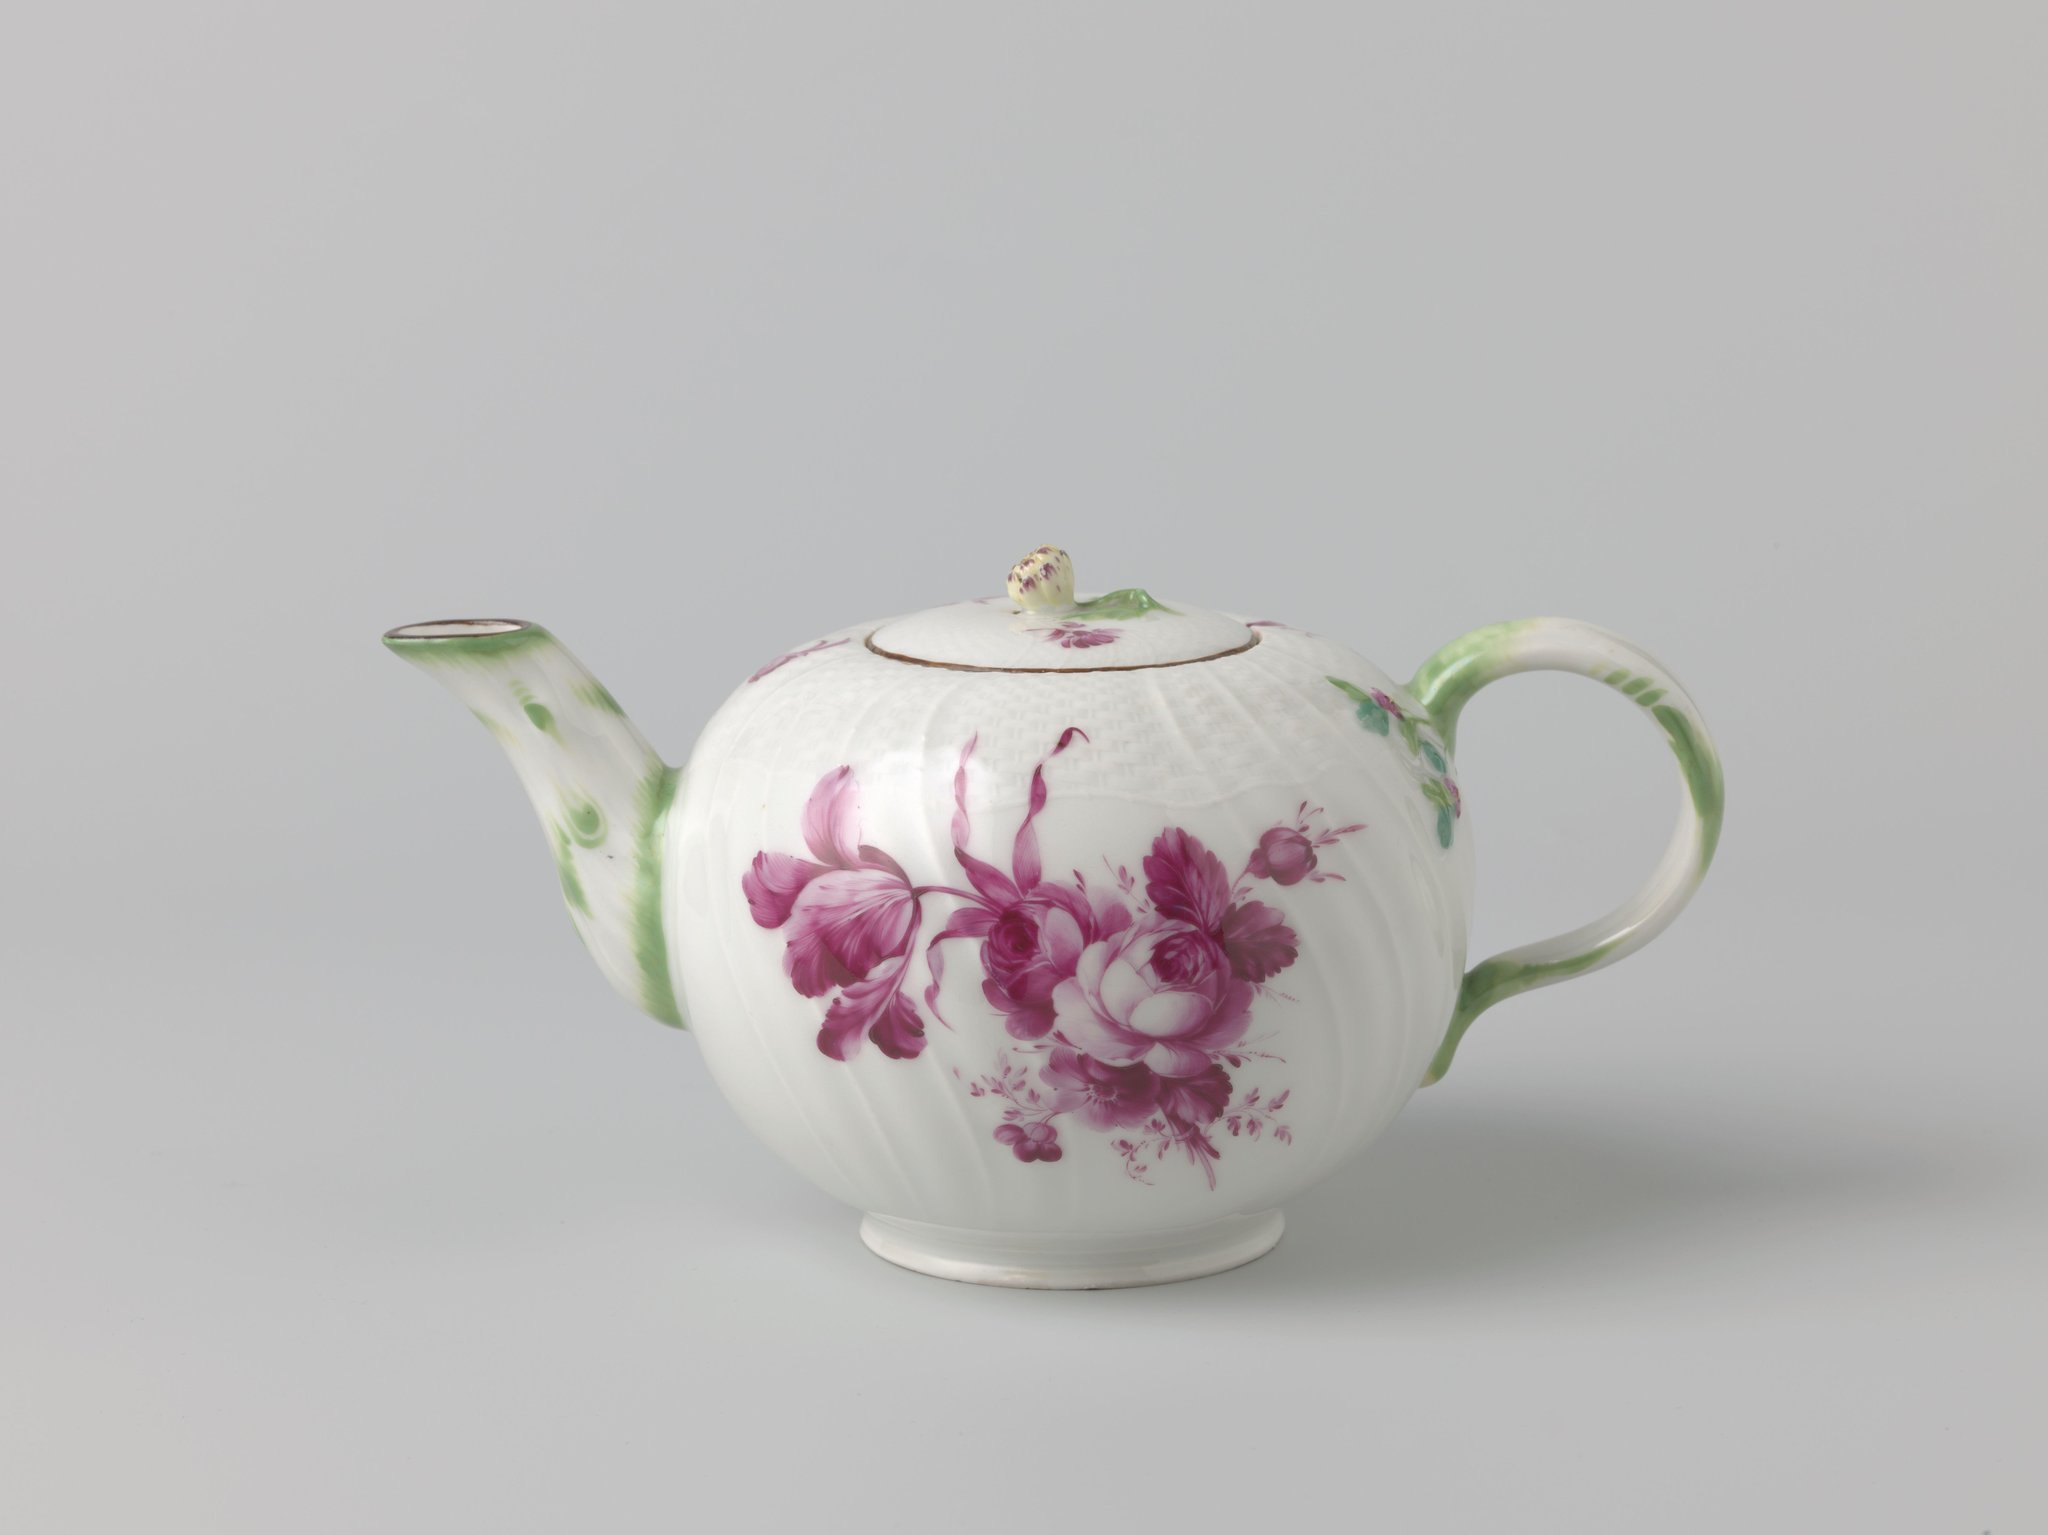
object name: lid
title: Deksel van theepot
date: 1778-1782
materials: porcelain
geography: loosdrecht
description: Deksel bedekt met een vlechtwerkpatroon met ribben in reliëf. De dekselknop in de vorm van een bloem aan stengel met bladeren is beschilderd in groen, geel en bietenrood. De dekselrand heeft een bruine bies.